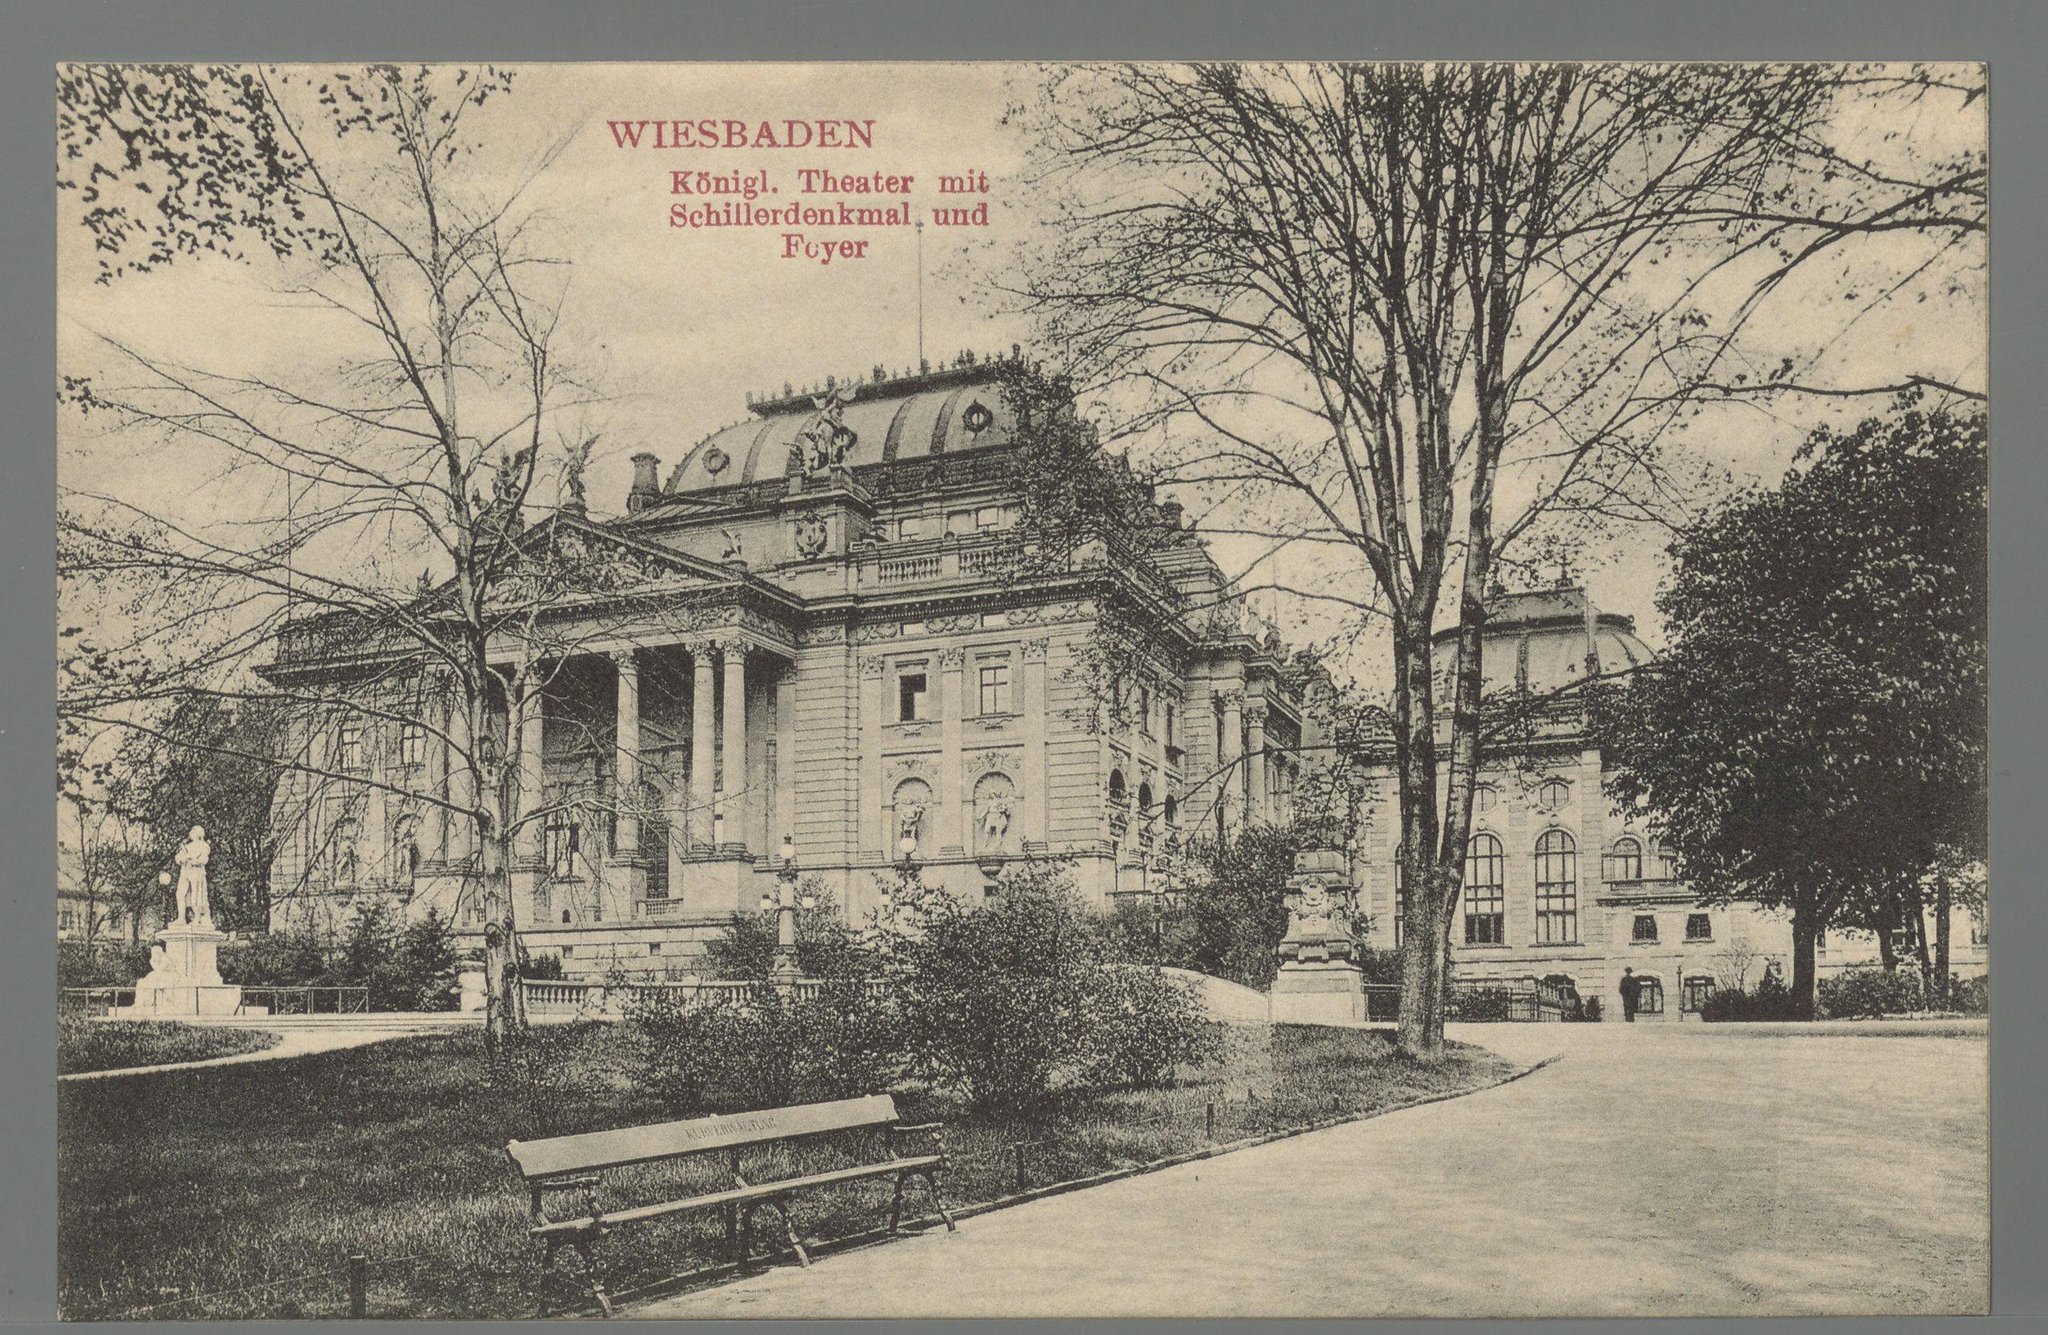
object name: photomechanical print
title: Wiesbaden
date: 1907-1908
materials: cardboard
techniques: photograph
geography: wiesbaden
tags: foyer ~ theatre, etc.